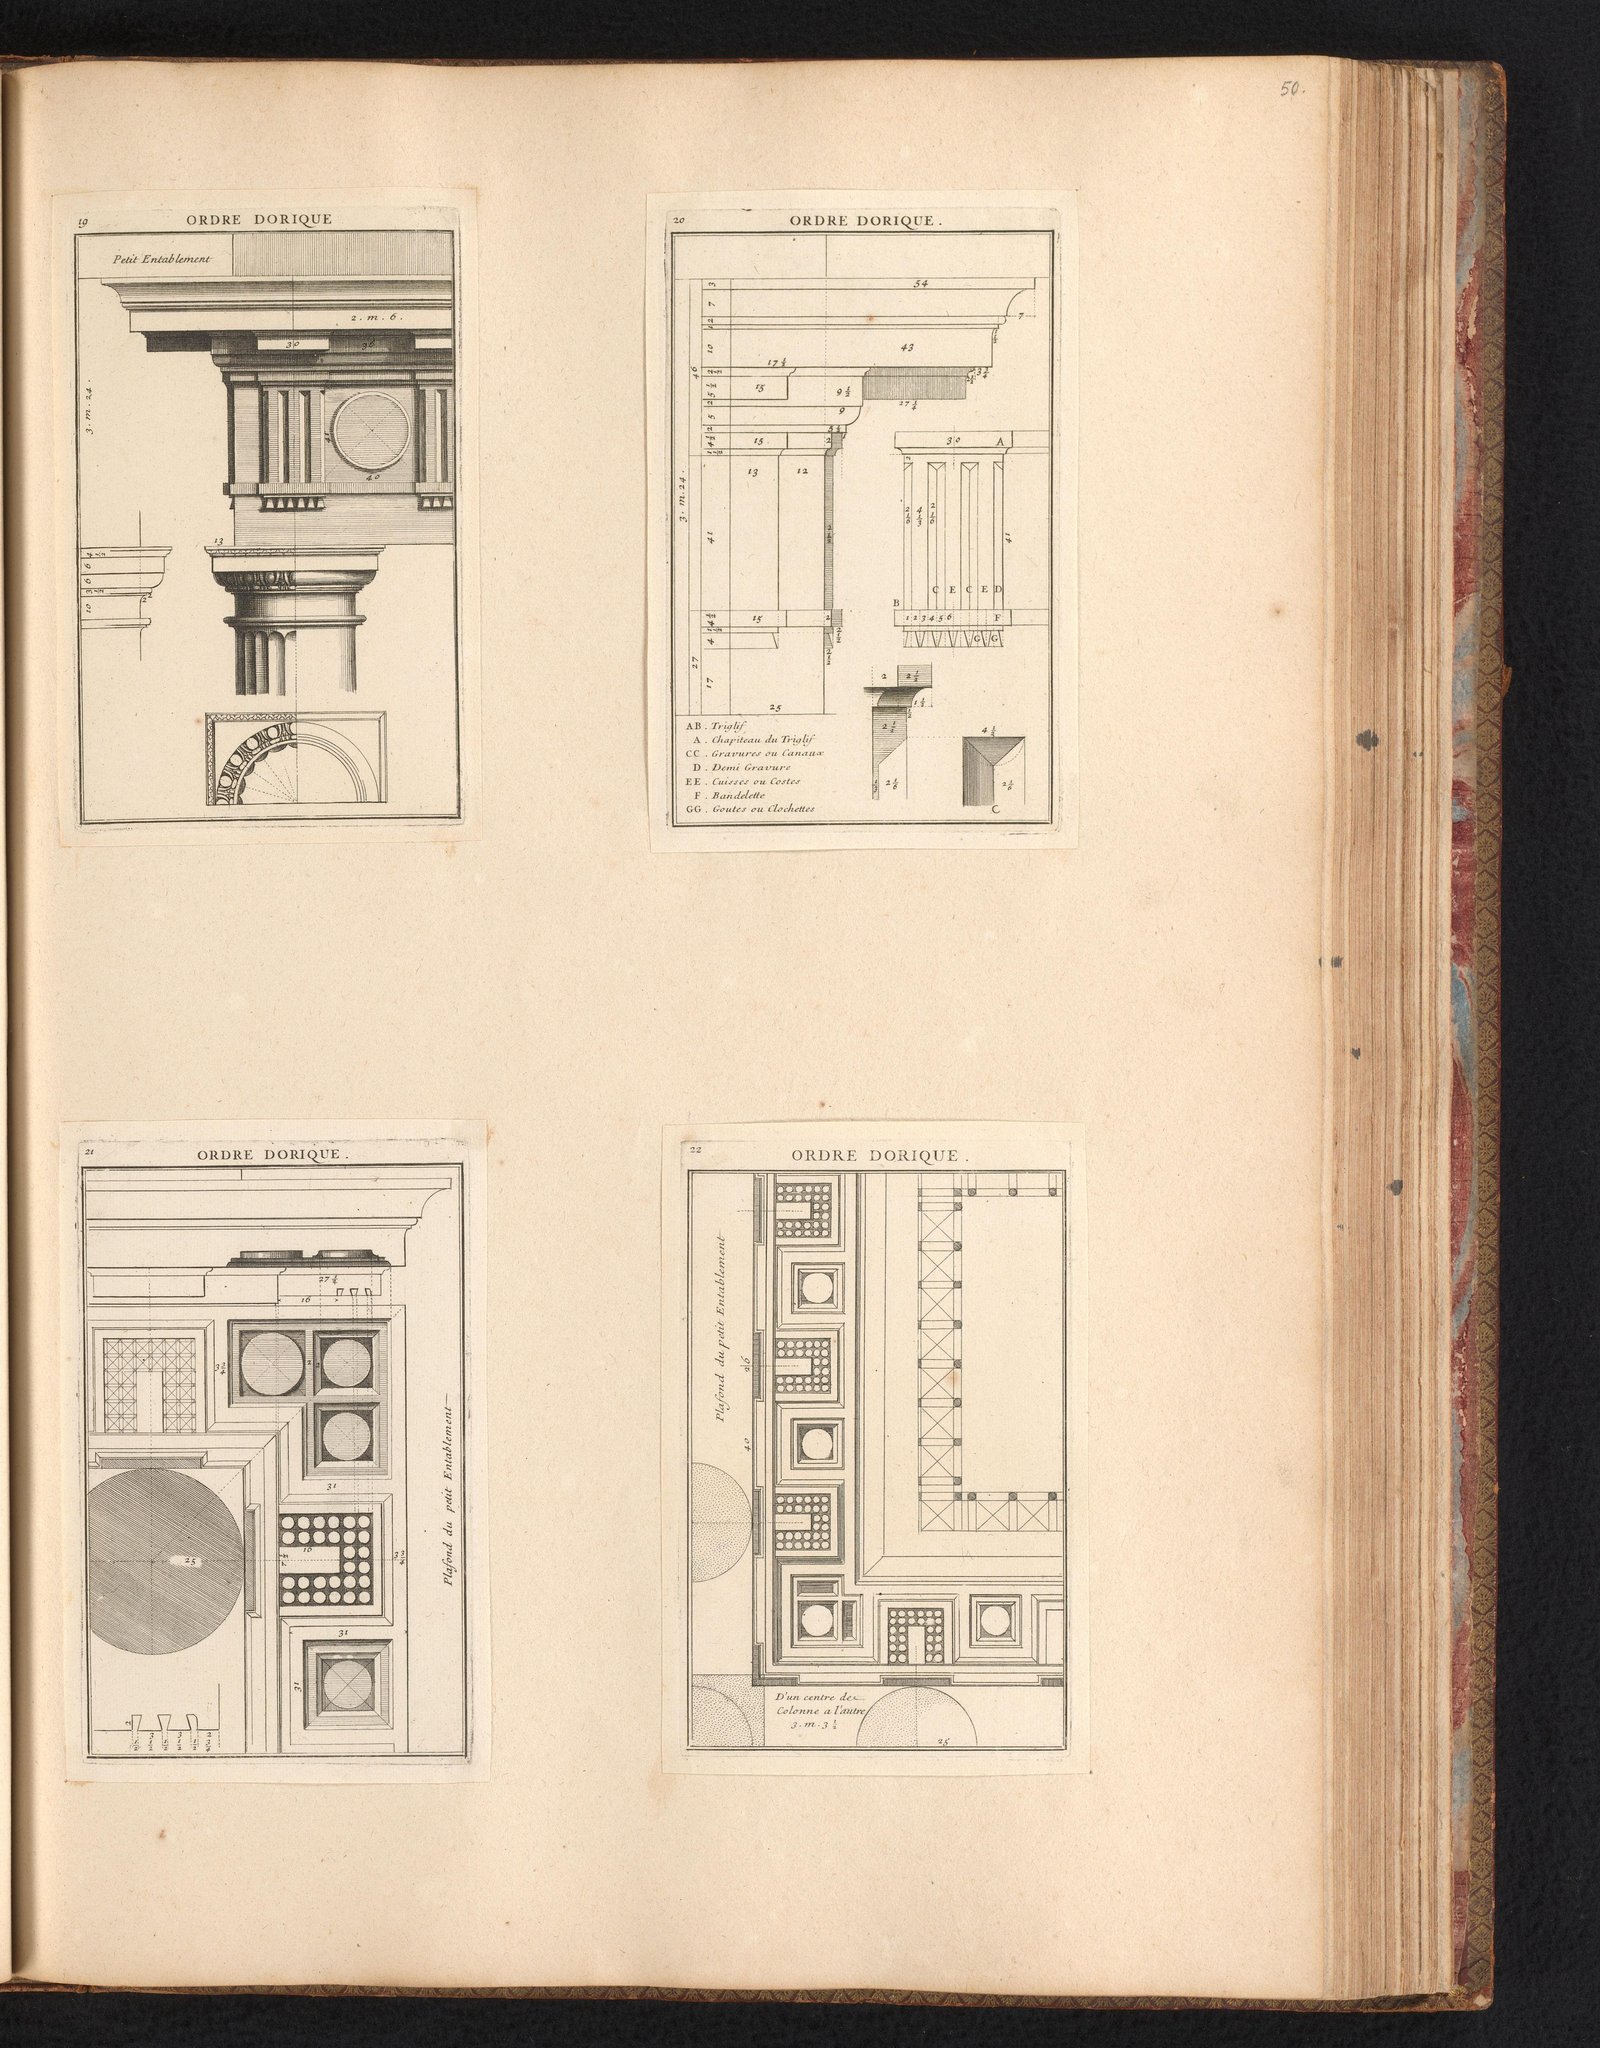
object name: album leaf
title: Ordre Dorique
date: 1714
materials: paper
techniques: etching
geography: paris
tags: doric order ~ architecture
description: Prenten uit: Leclerc, Sébastien (I). Traité d'architecture. Parijs: Pierre François Giffart, 1714.